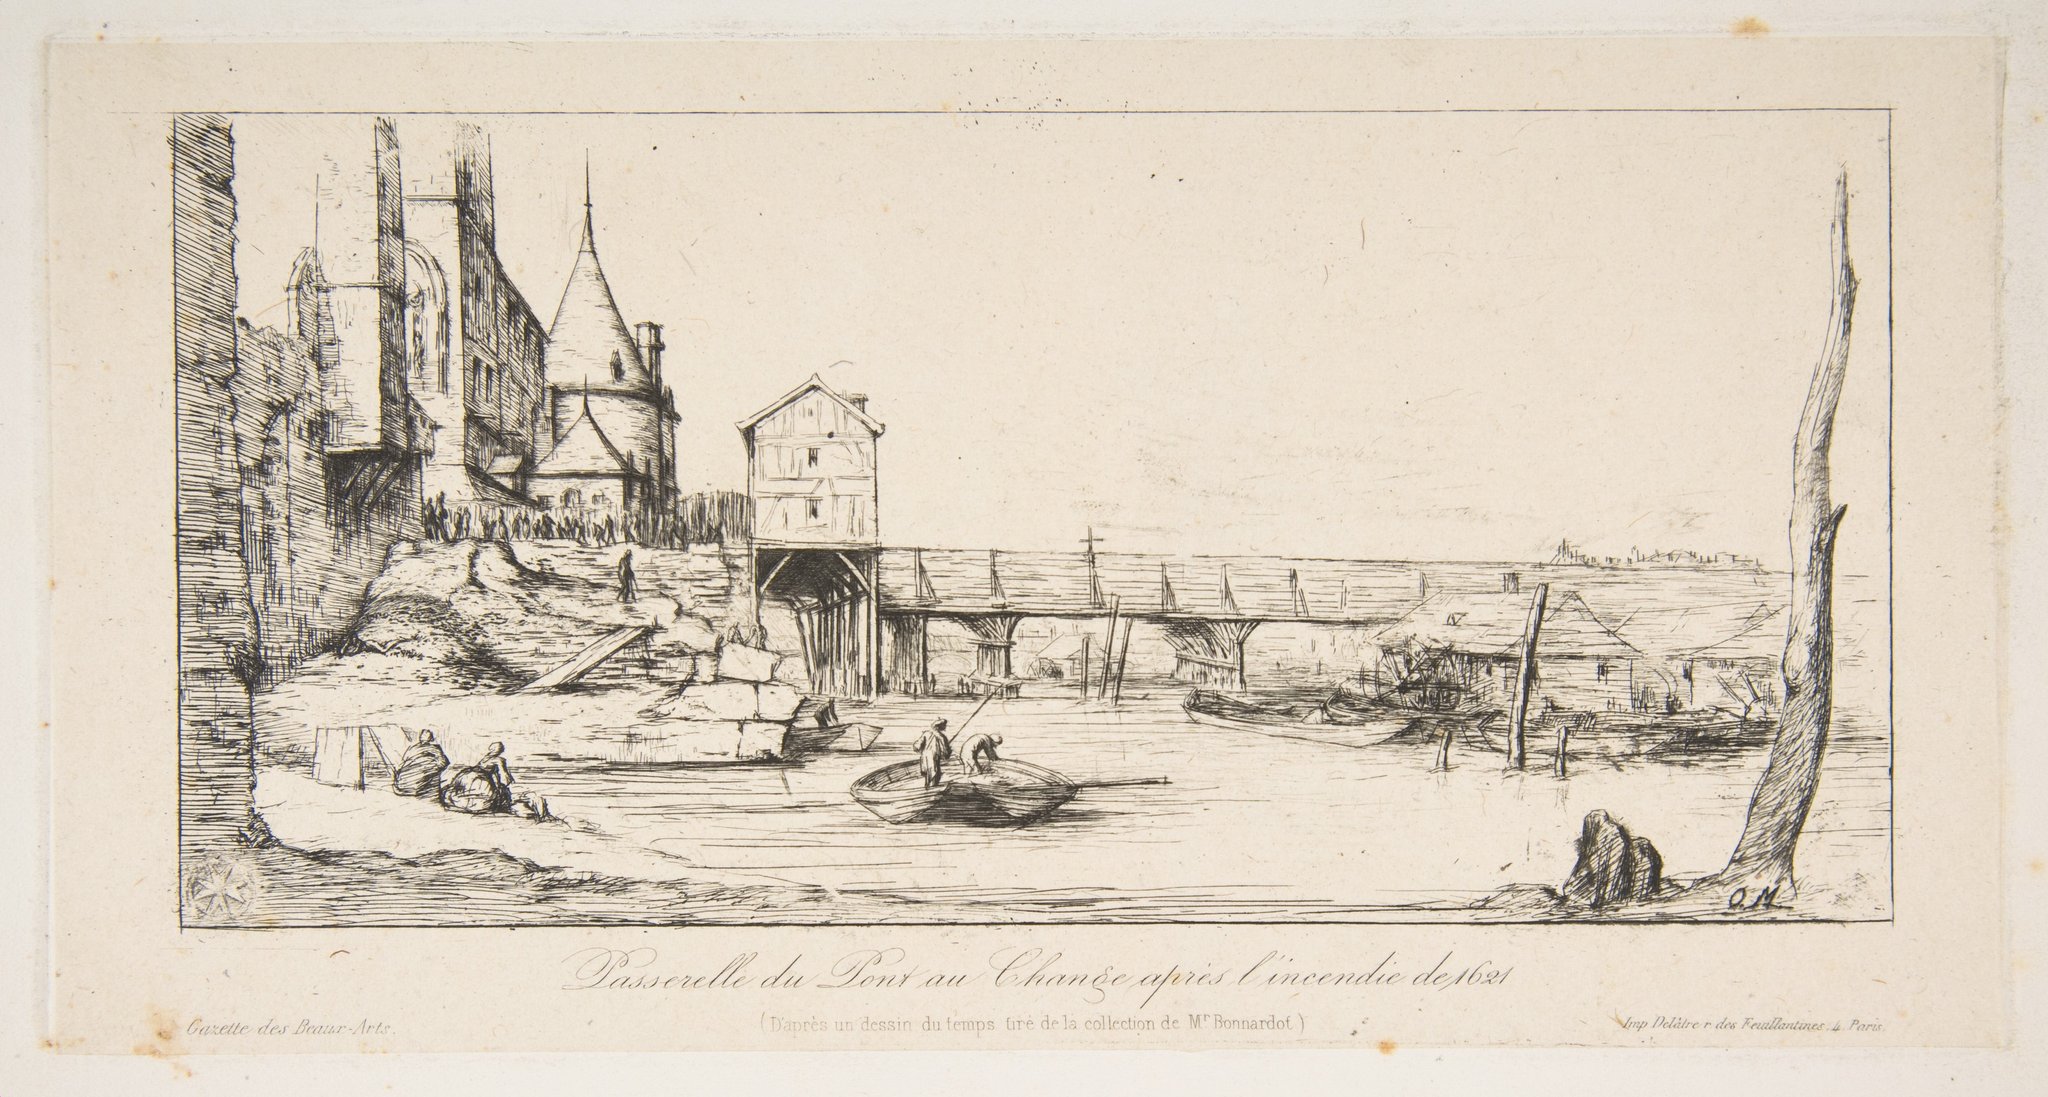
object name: print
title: The footbridge temporarily replacing the Pont-au-Change, Paris, after the fire of 1621, after della Bella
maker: charles meryon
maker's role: artist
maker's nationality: french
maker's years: 1821-1868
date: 1860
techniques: etching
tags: bridges,boats,paris